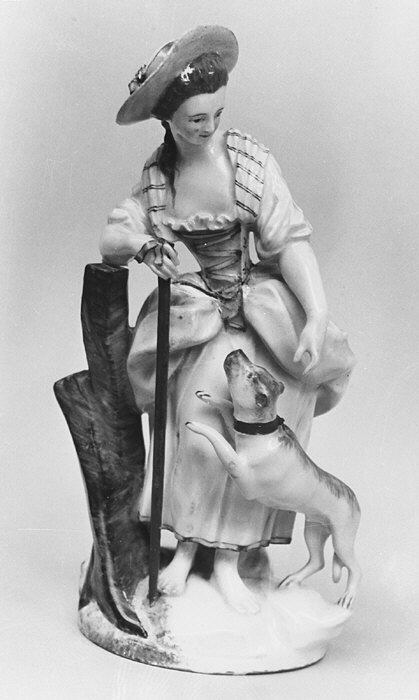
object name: figure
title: Shepherdess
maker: zurich pottery and porcelain factory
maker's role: factory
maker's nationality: swiss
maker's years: 1763-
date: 1775-1780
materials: hard paste porcelain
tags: women,dogs,shepherds